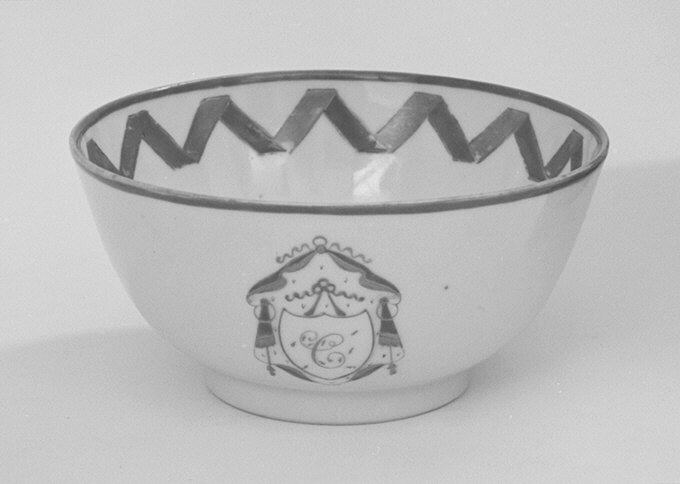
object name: teacup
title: Tea cup (part of a set)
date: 1790-1800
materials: hard paste porcelain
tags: coat of arms